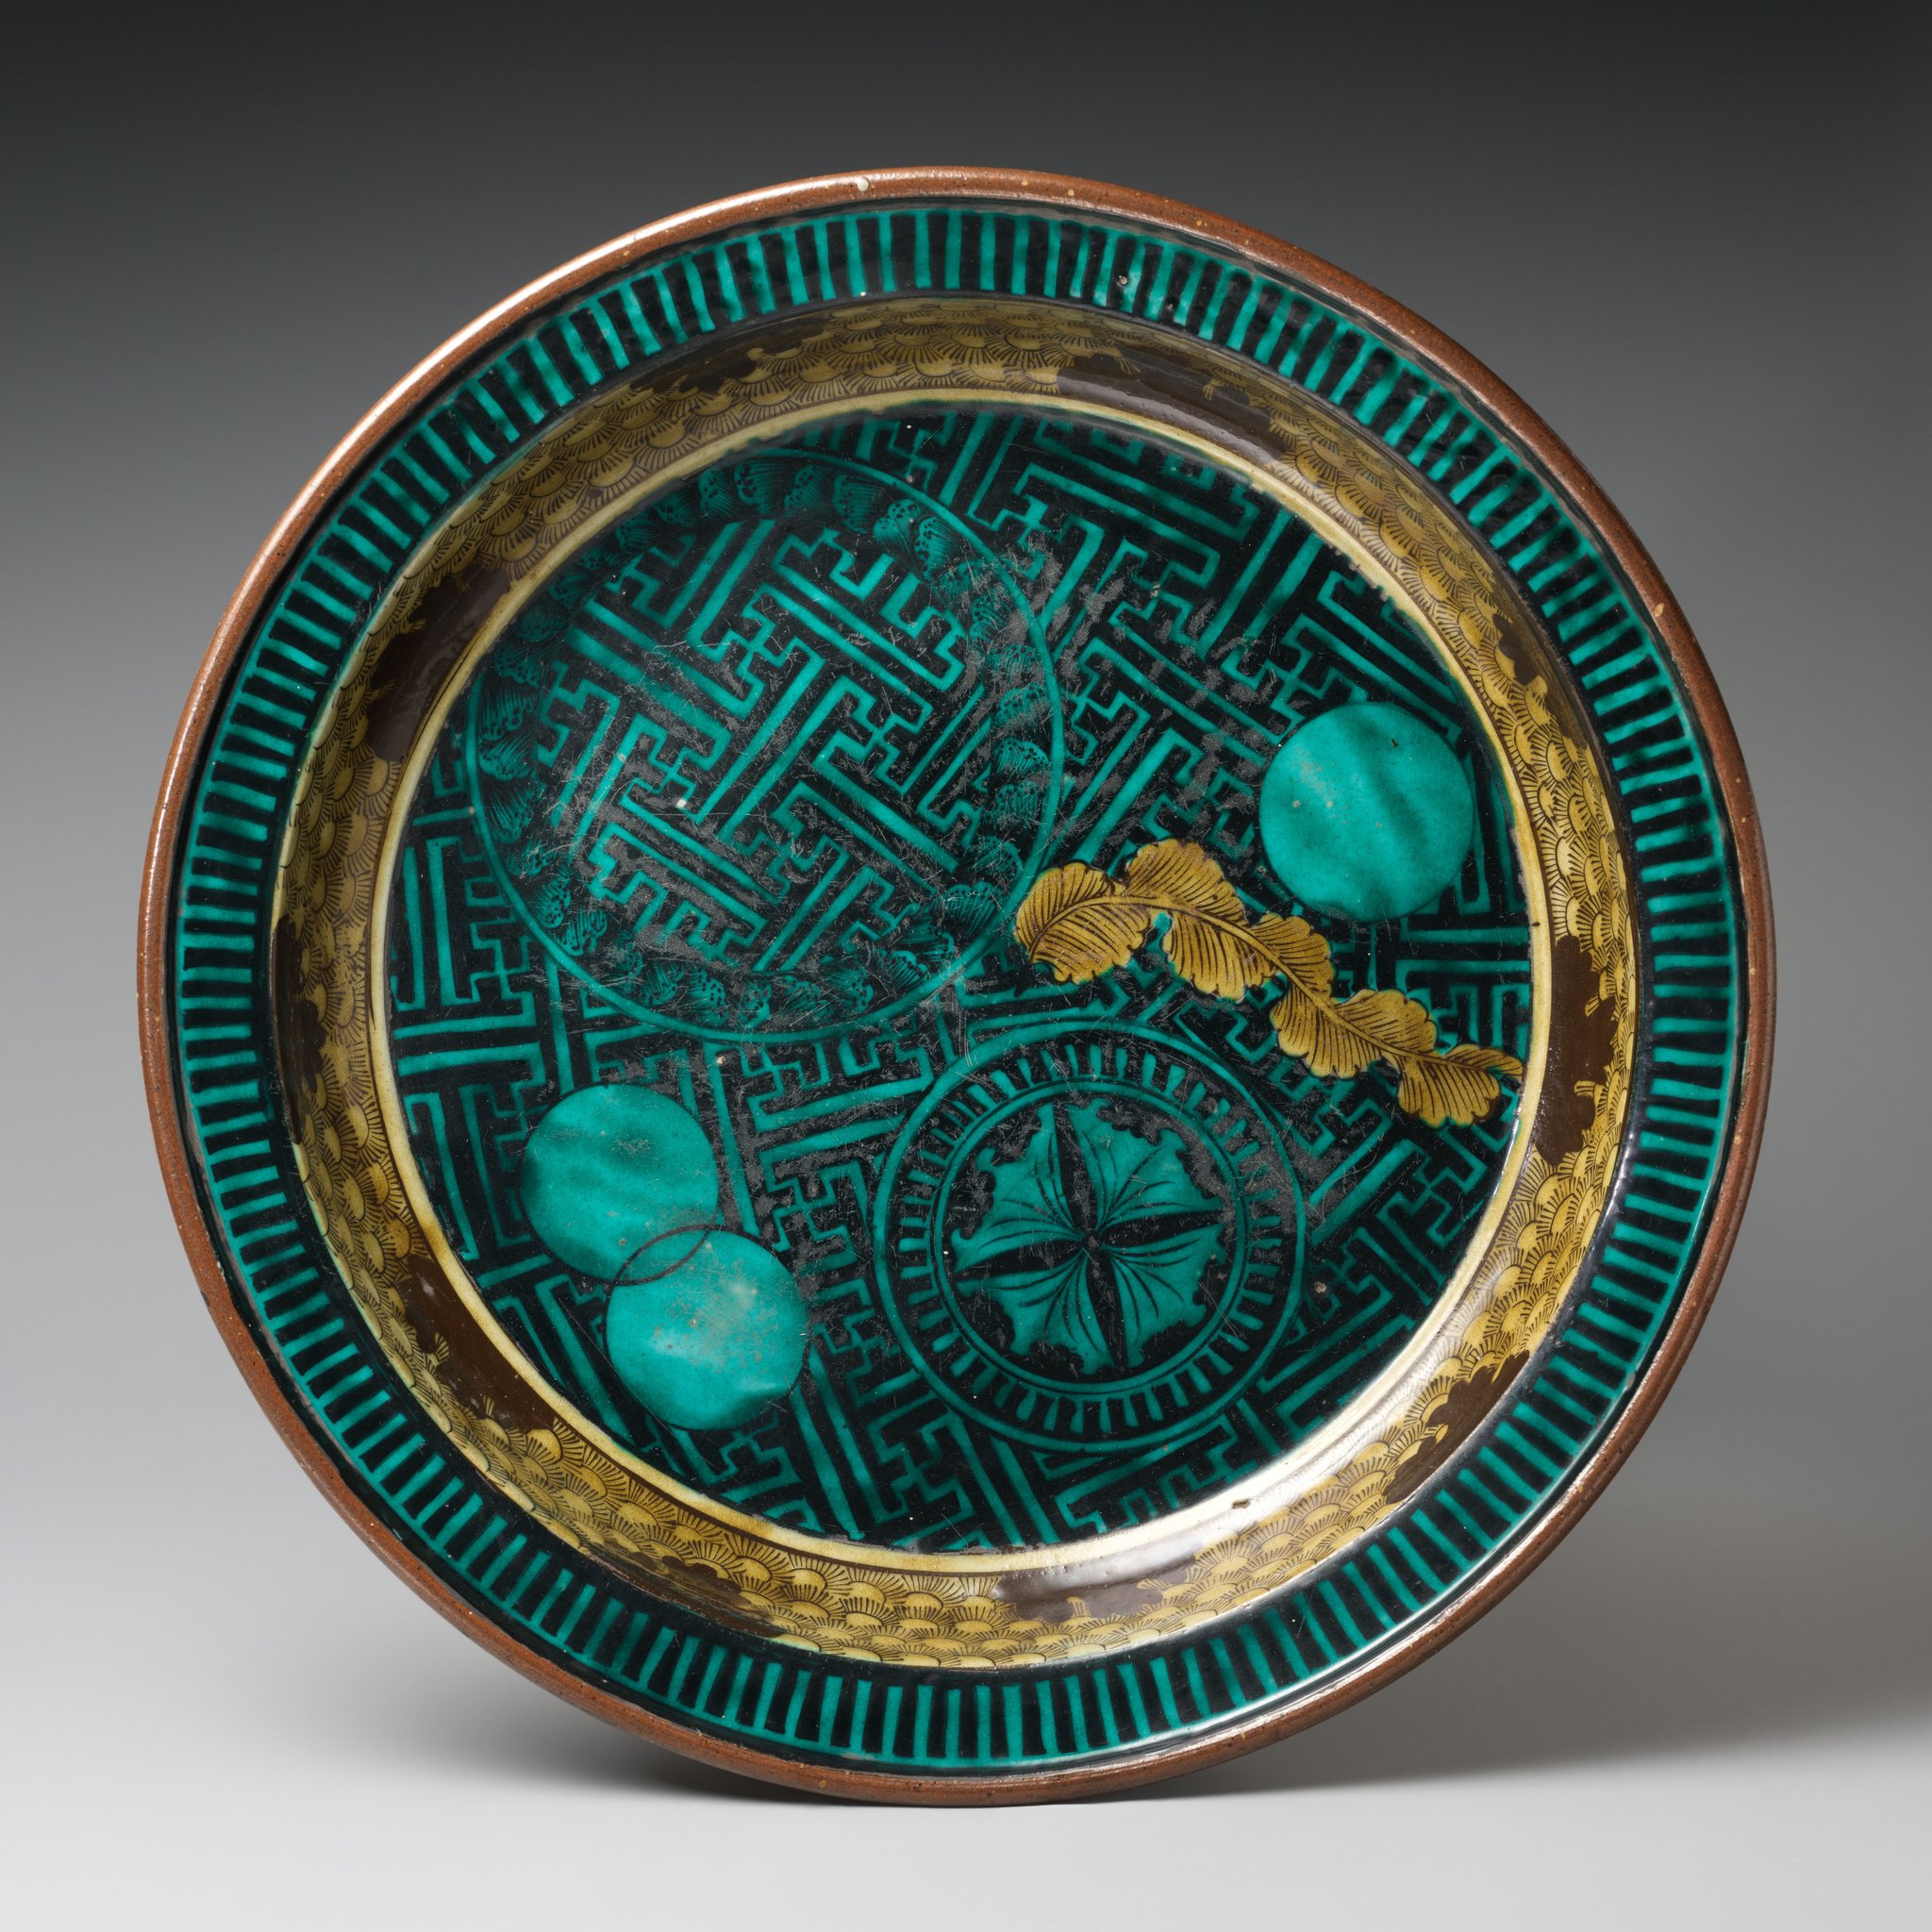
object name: plate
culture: japanese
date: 1701-1800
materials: pottery